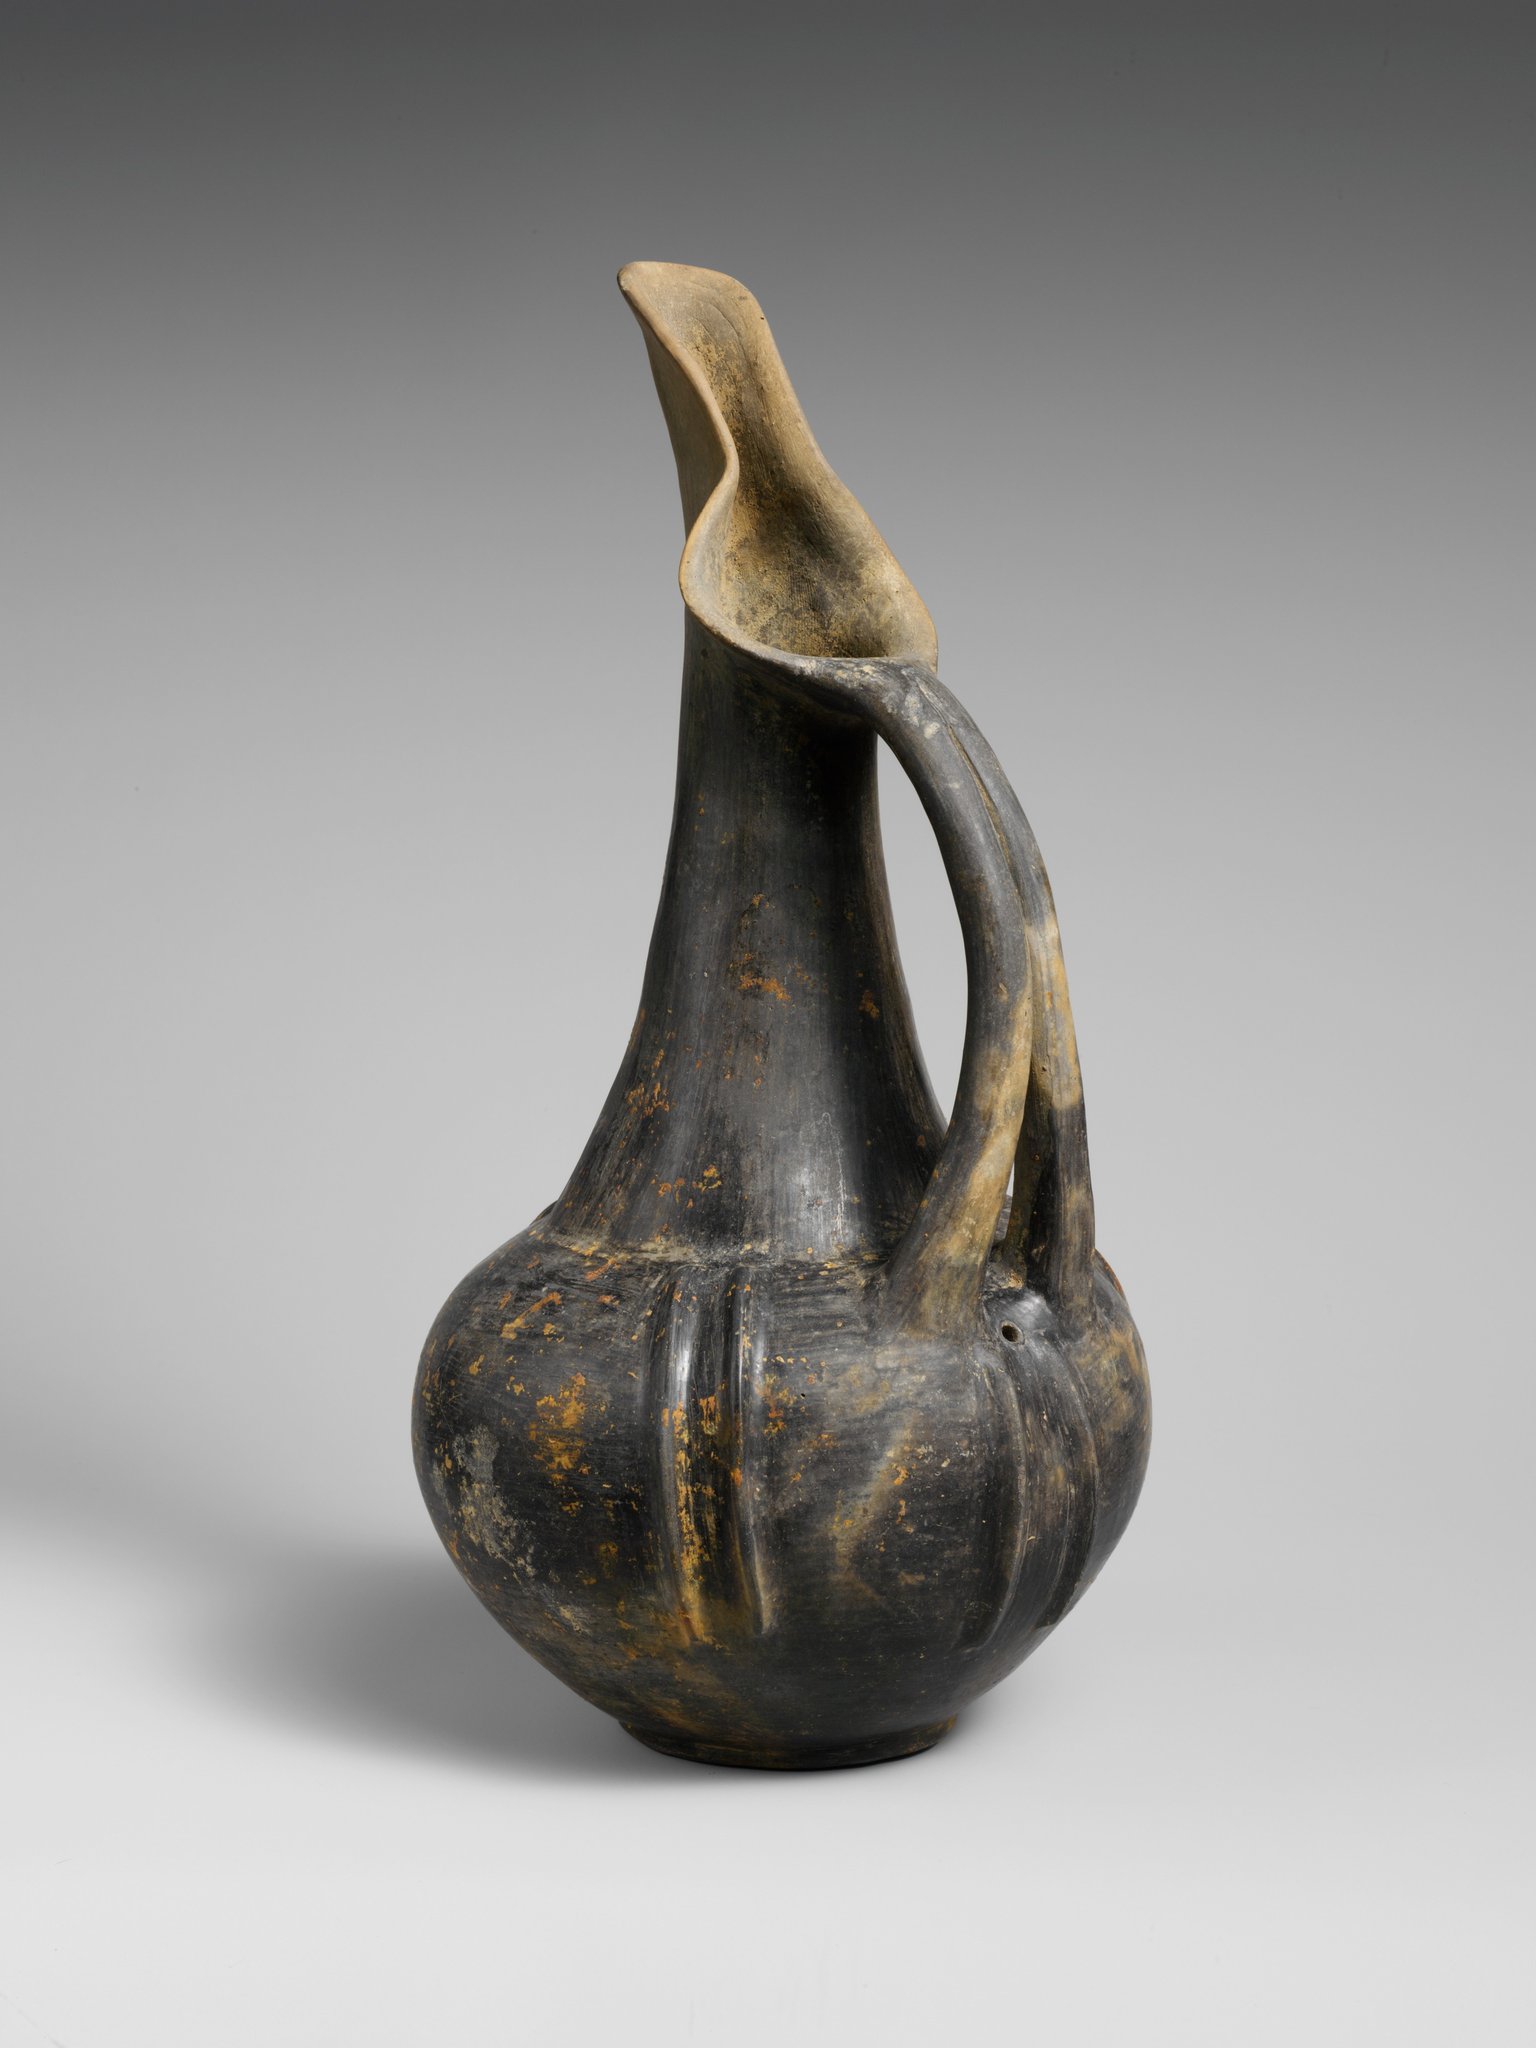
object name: jug, beak spouted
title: Terracotta beak-spouted jug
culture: villanovan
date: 750-690 BCE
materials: terracotta